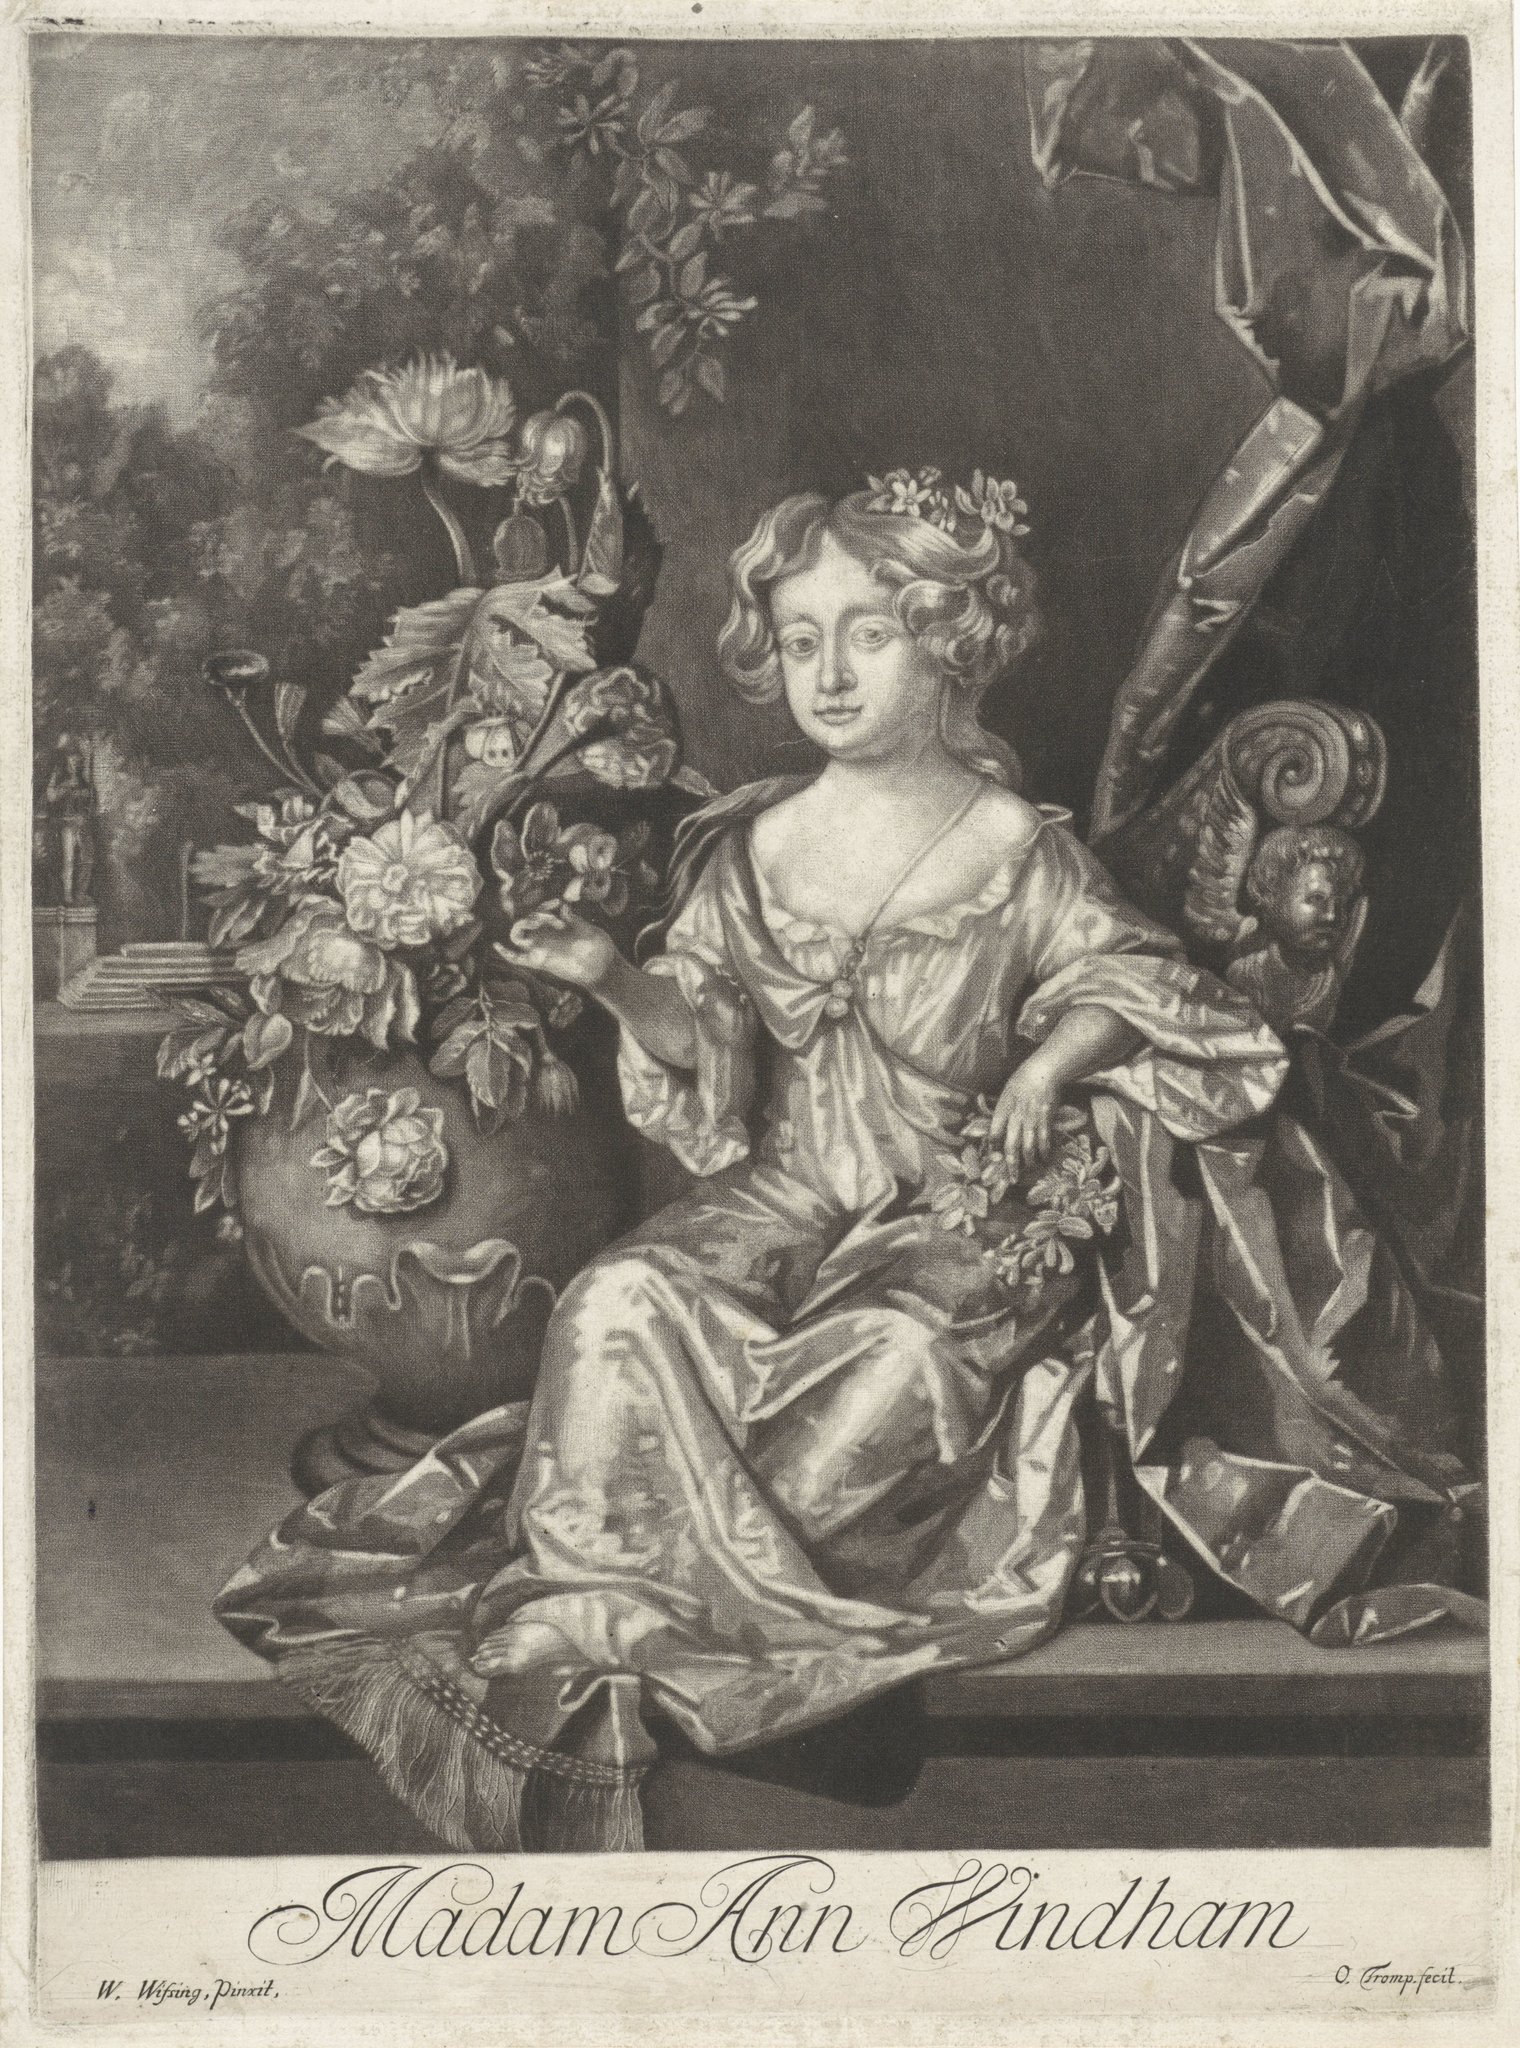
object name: print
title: Portret van Anne Windham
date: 1650-1690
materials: paper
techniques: engraving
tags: flowers, garden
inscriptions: collector's mark: Lugt 2228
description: Anne Windham als kind. Ze zit naast een vaas met bloemen. Op de achtergrond een tuin.